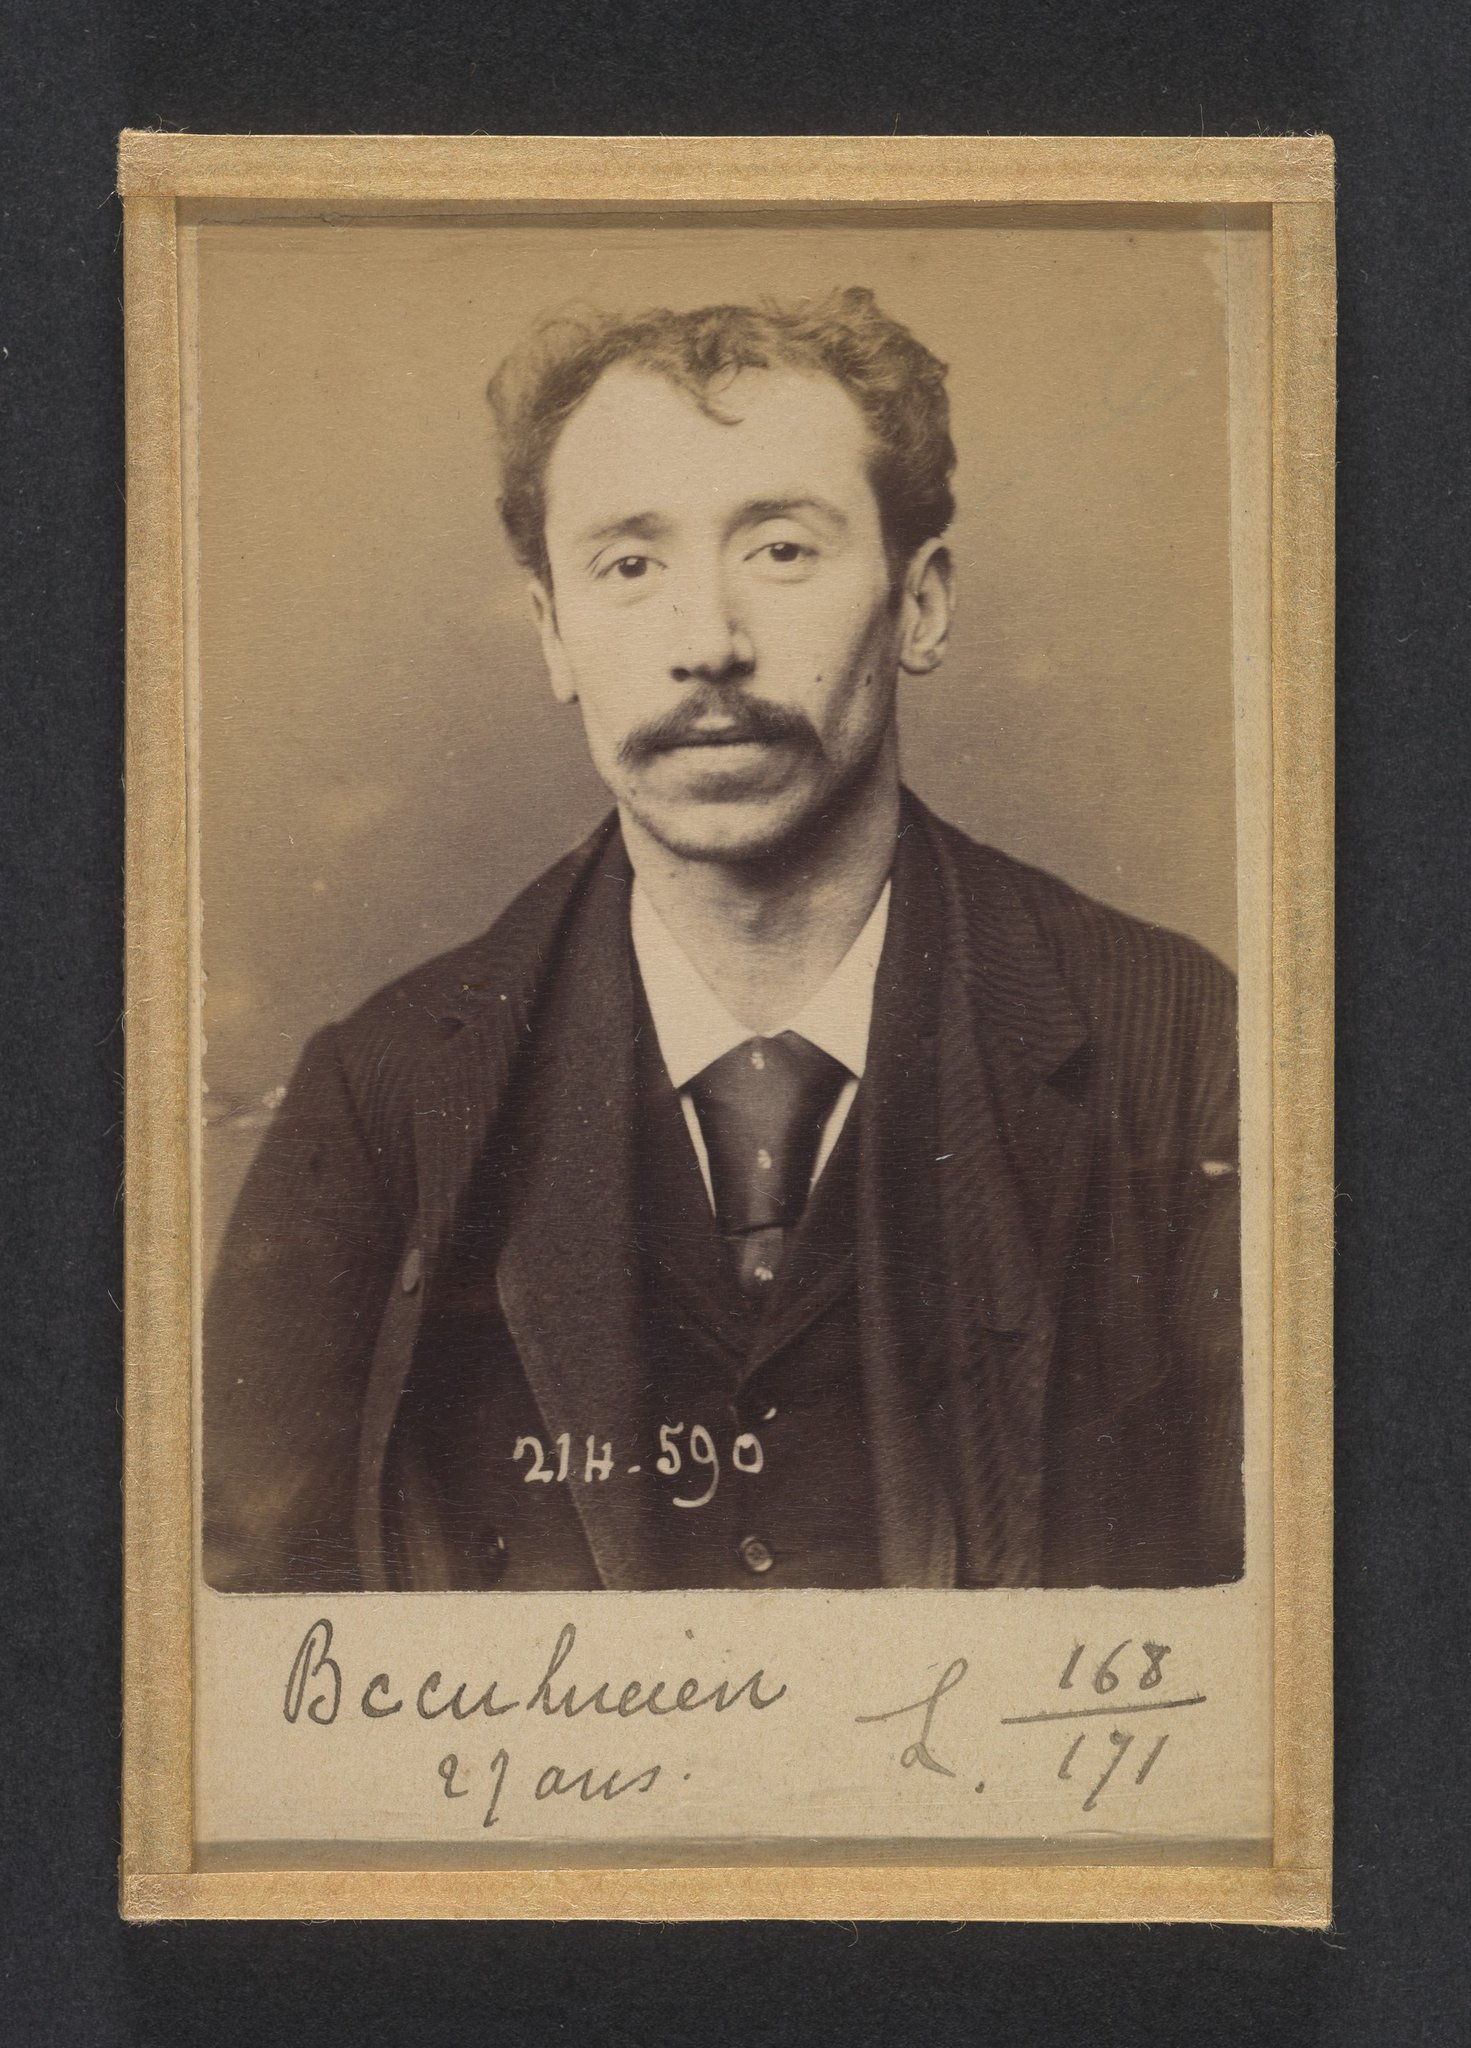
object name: mugshot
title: Becu. Lucien. 27 ans, né à la Conté d'Abigny (Pas-de-Calais). Garçon de café. Pas de motif. 22/2/94.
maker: alphonse bertillon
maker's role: artist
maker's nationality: french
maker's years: 1853-1914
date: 1894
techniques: albumen silver print, glass negative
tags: men,portraits